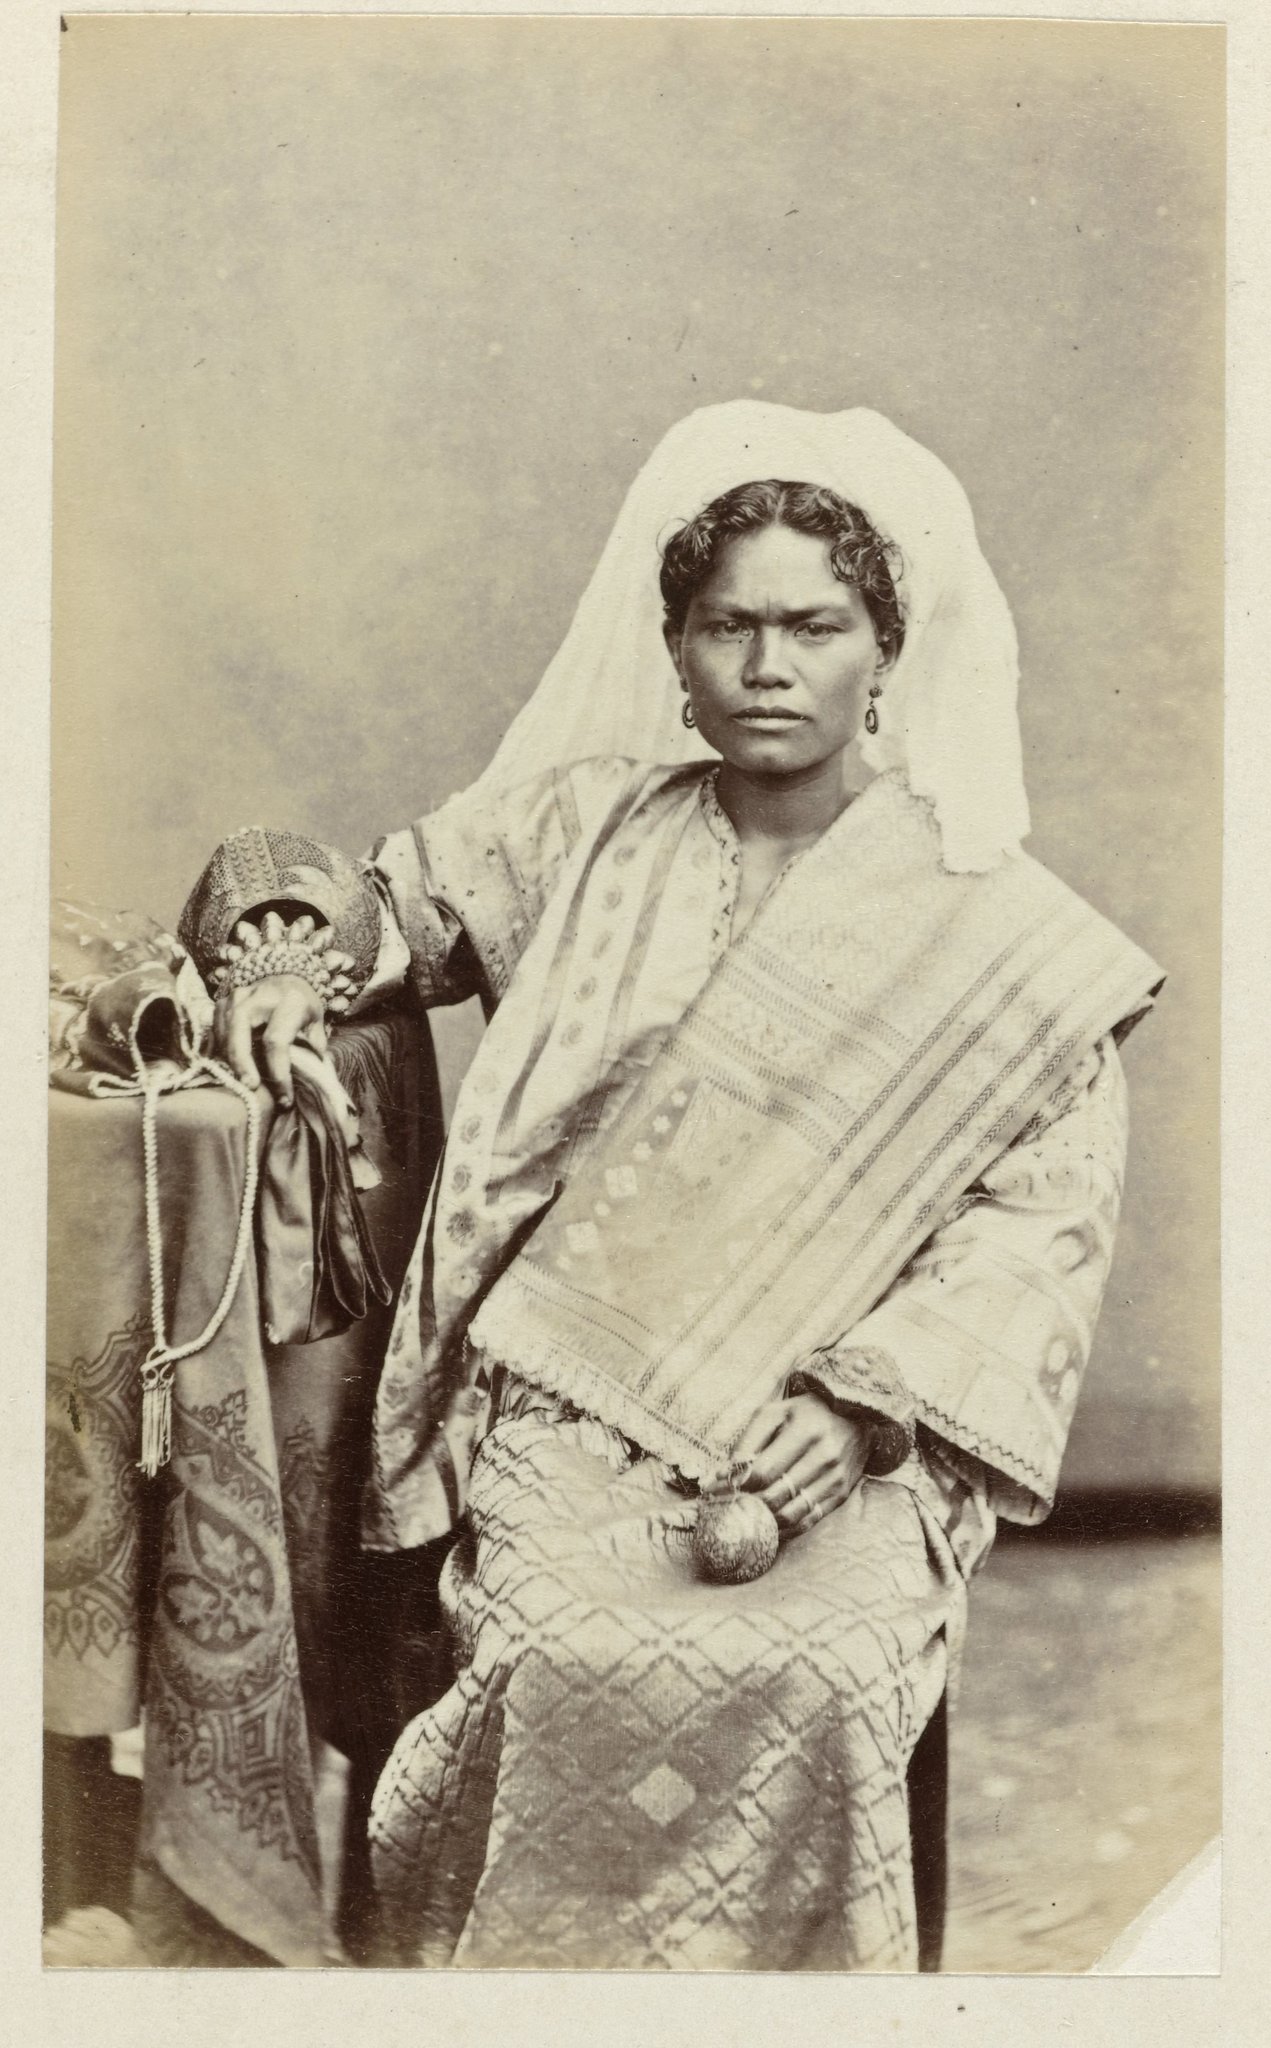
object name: photograph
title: Zittende vrouw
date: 1860-1890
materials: photographic support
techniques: albumen print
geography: celebes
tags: historical persons not known by name - bb - woman, java, batavia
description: Studioportret van een zittende vrouw, met armsieraden en schouderdoek. Ingeplakte foto in het fotoalbum getiteld: Gezichten van Java.